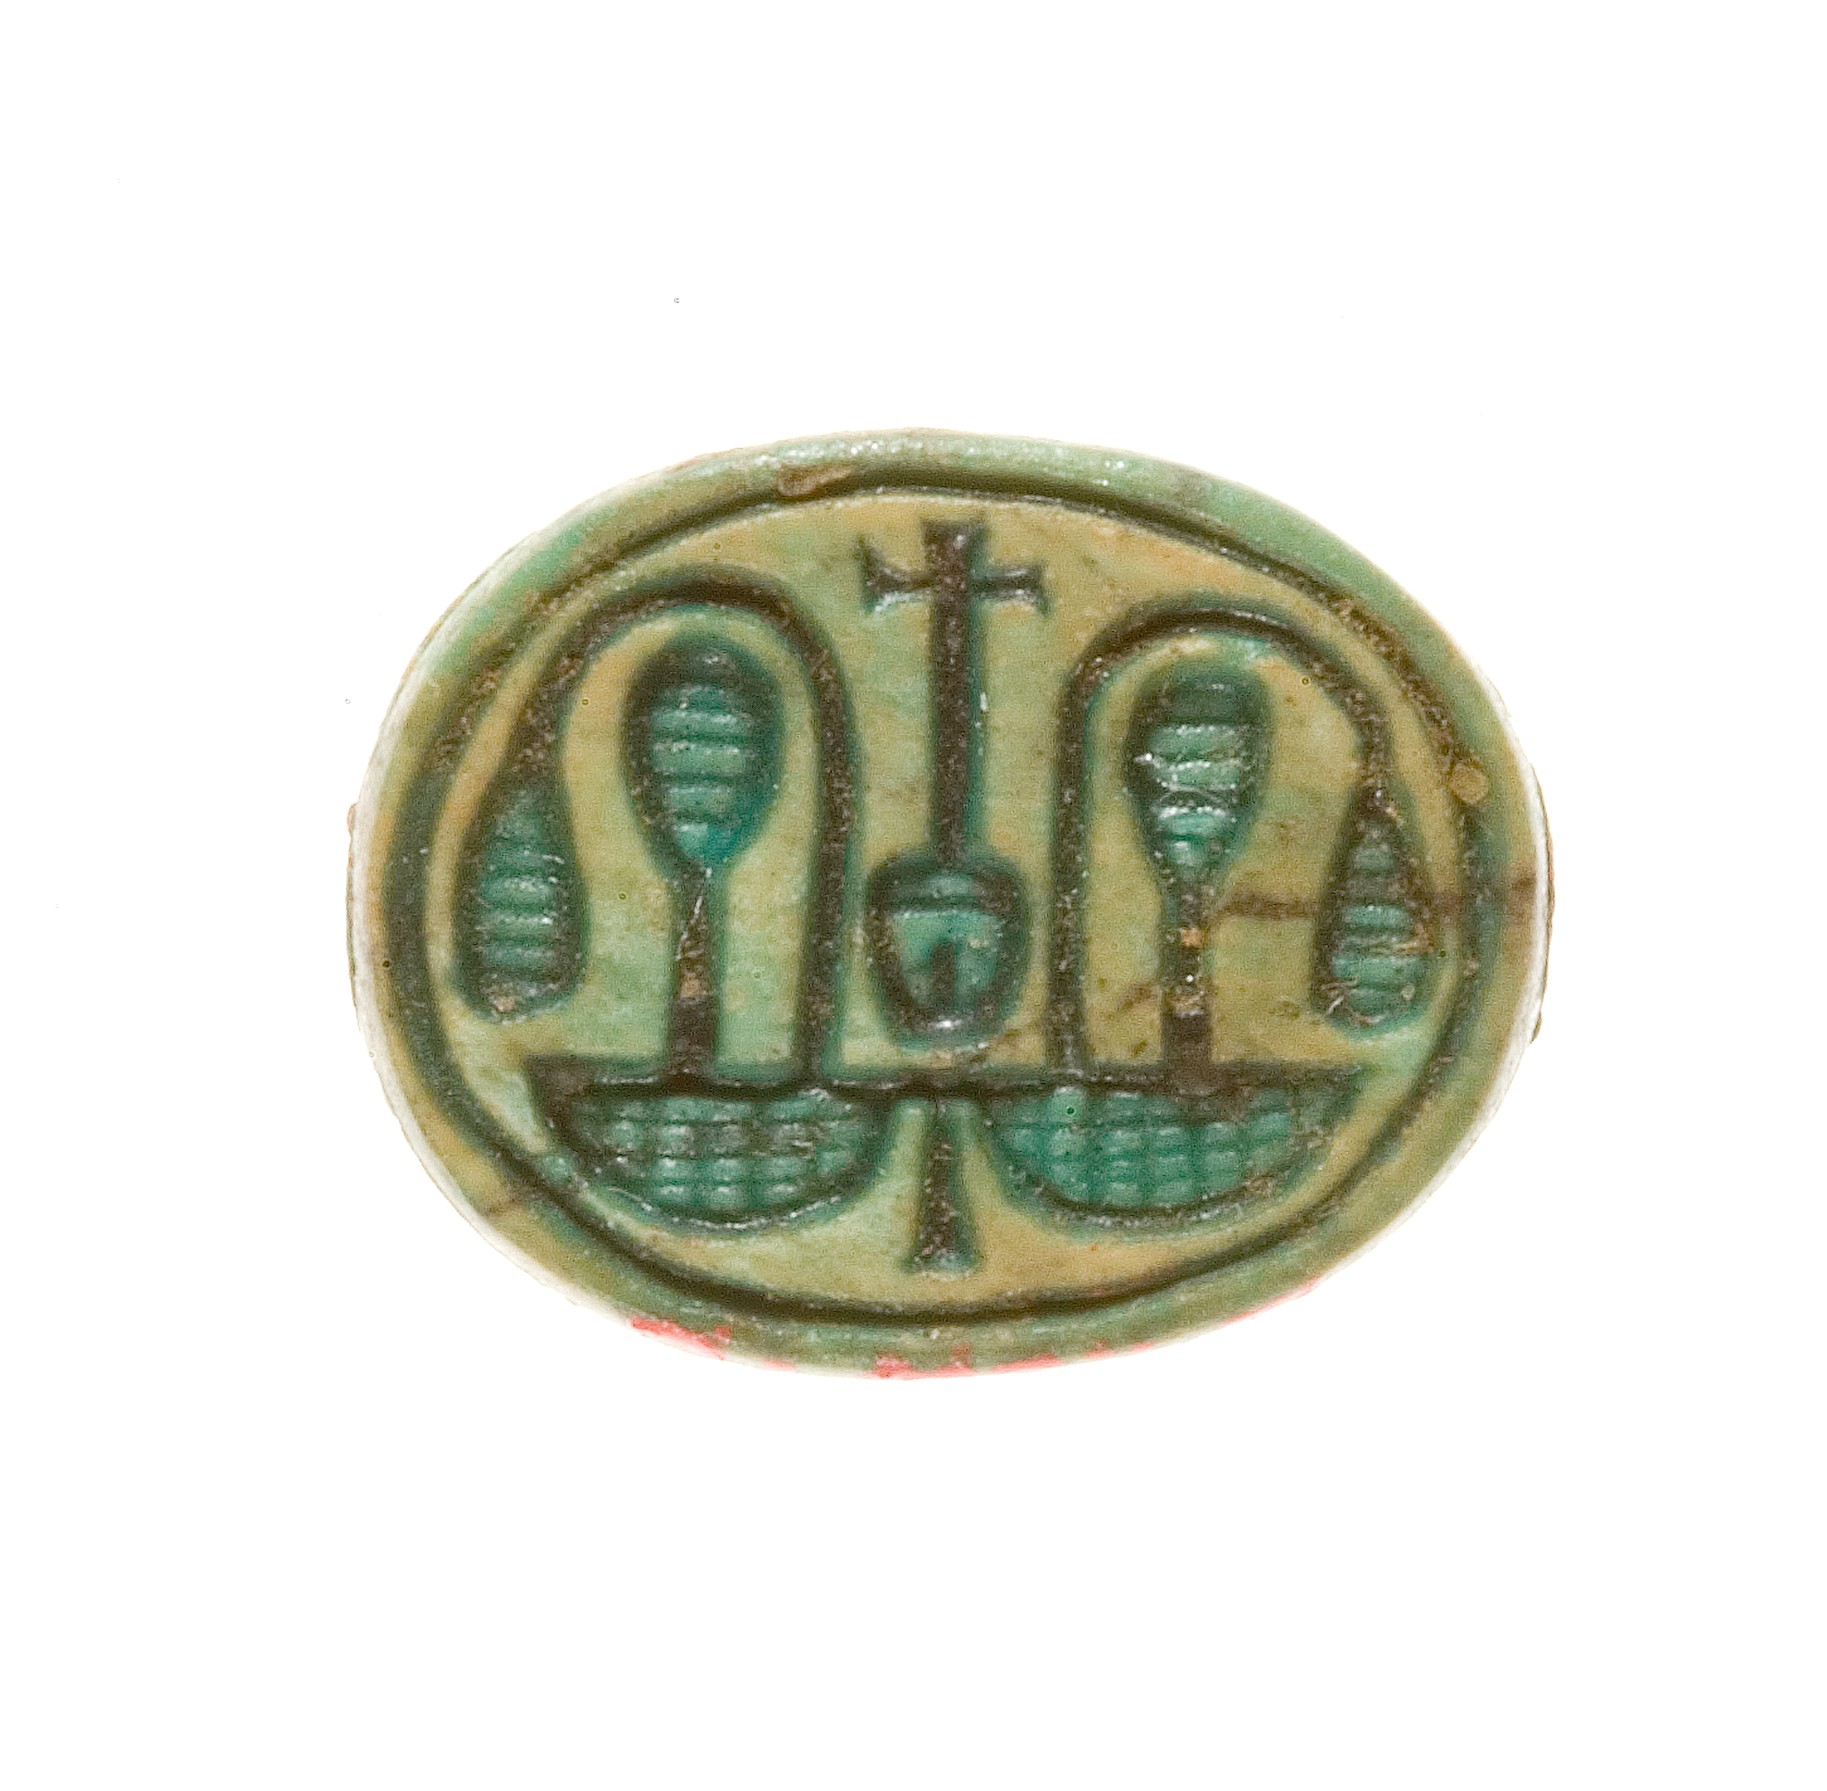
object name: scarab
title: Scarab Inscribed with a Decorative Motif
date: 1479-1458 BCE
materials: stone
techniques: glazing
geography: egypt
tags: hieroglyphs,scarabs